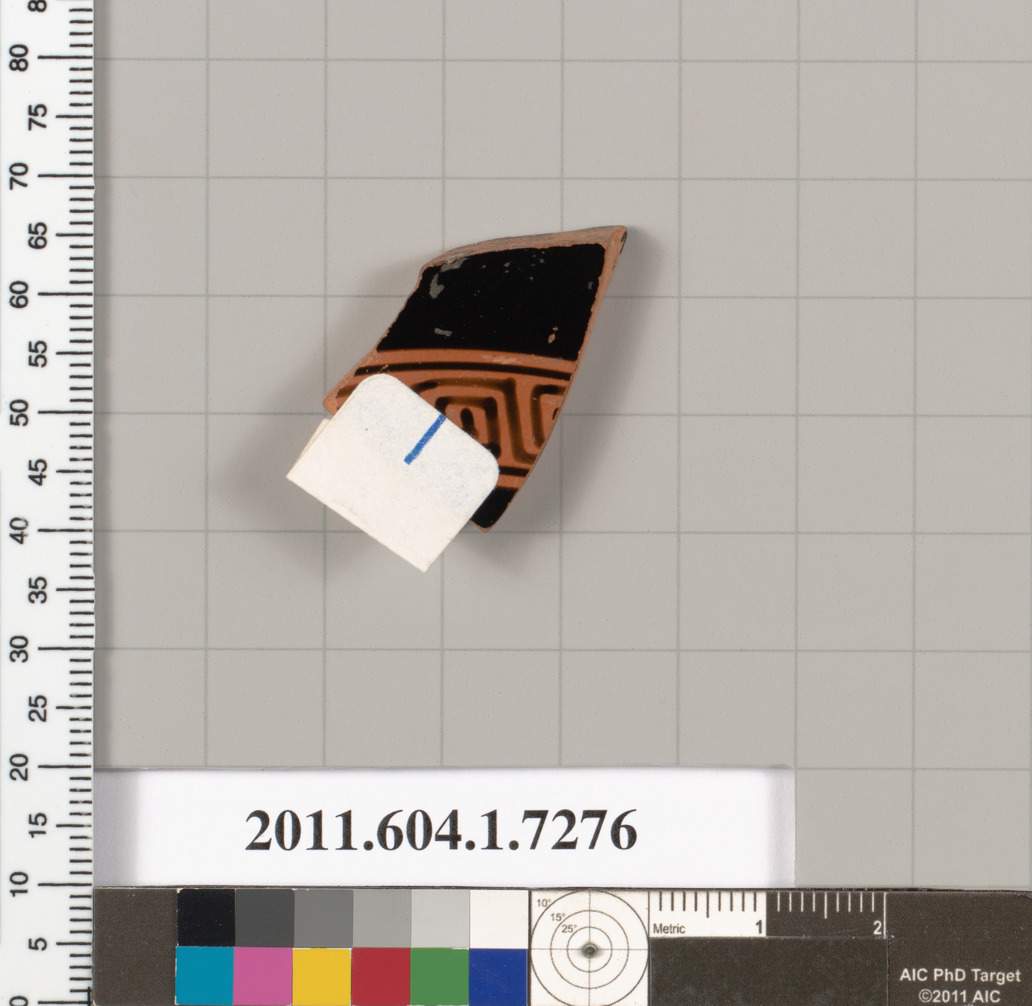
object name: kylix fragment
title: Terracotta fragment of a kylix (drinking cup)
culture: greek, attic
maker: makron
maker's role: artist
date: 500-480 BCE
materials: terracotta